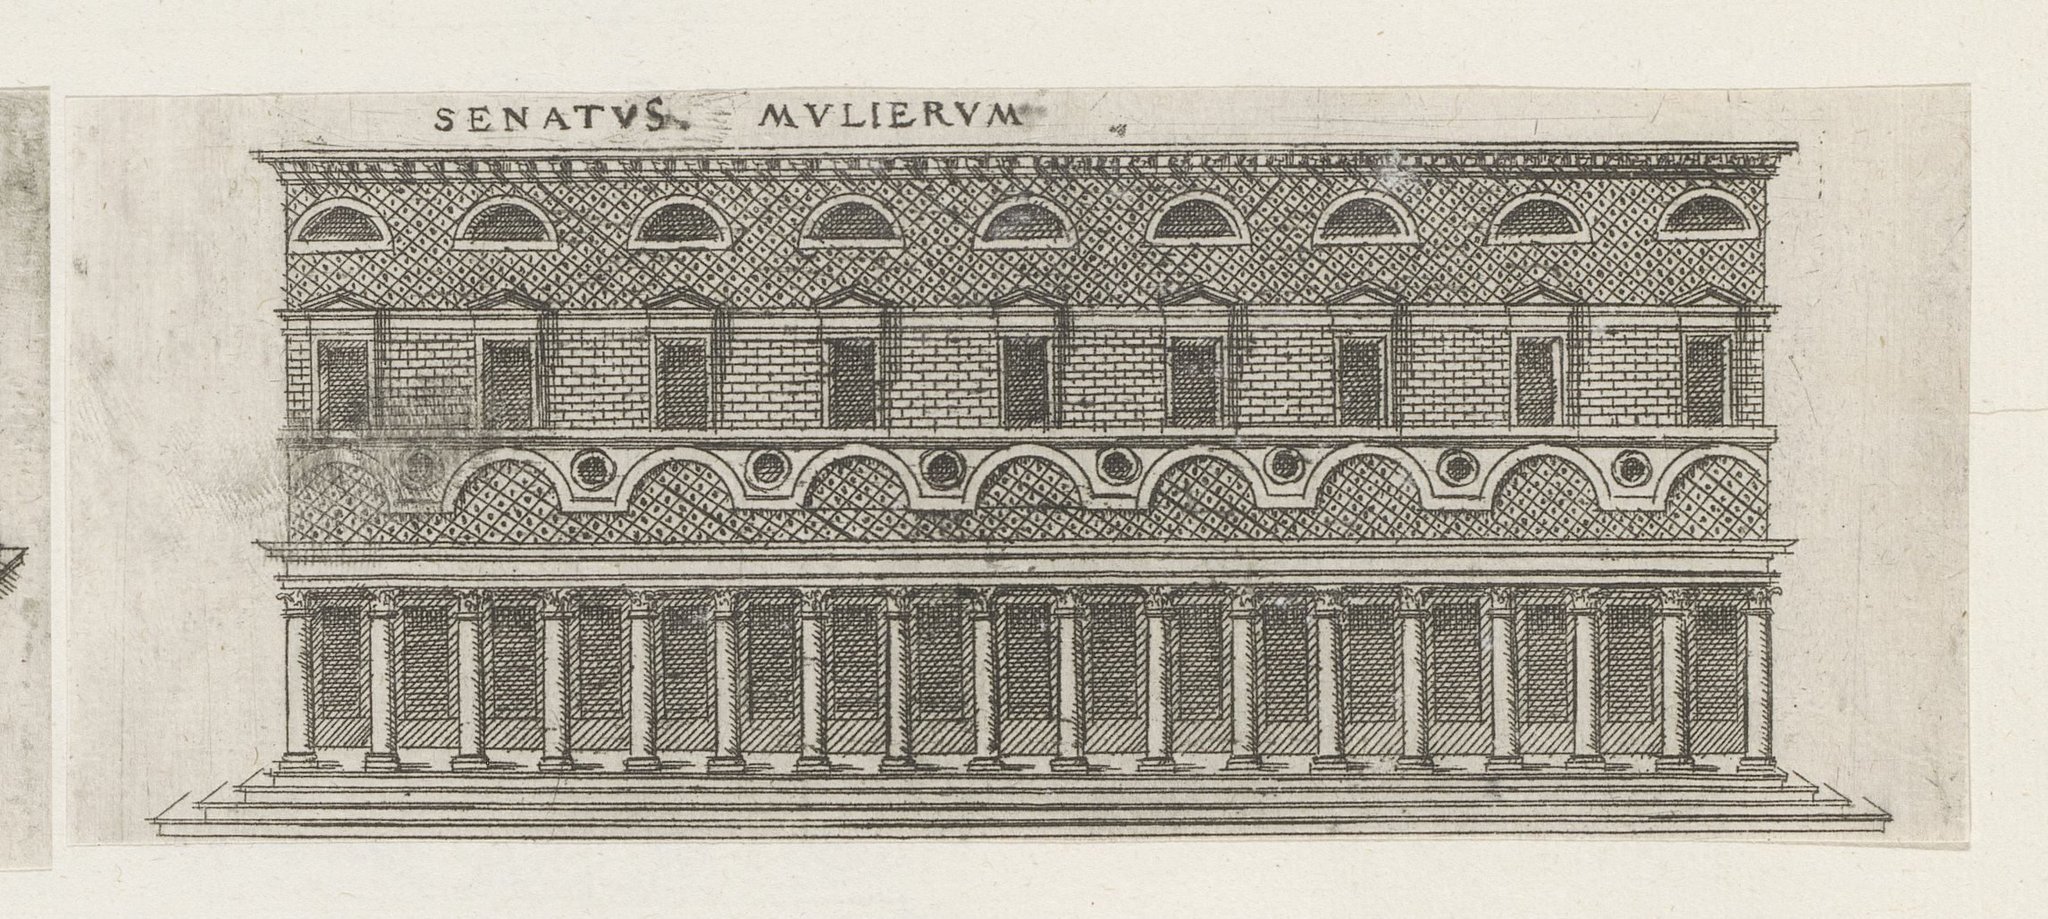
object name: album leaf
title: Senatus Mulierum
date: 1584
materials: paper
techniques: etching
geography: paris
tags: representation of real building (either existing or having existed), rome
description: Deze prent maakt deel uit van een serie van 98 prenten gedrukt op 48 bladen. De bladen zijn verknipt en een selectie van de losse prenten is in dit album geplakt.